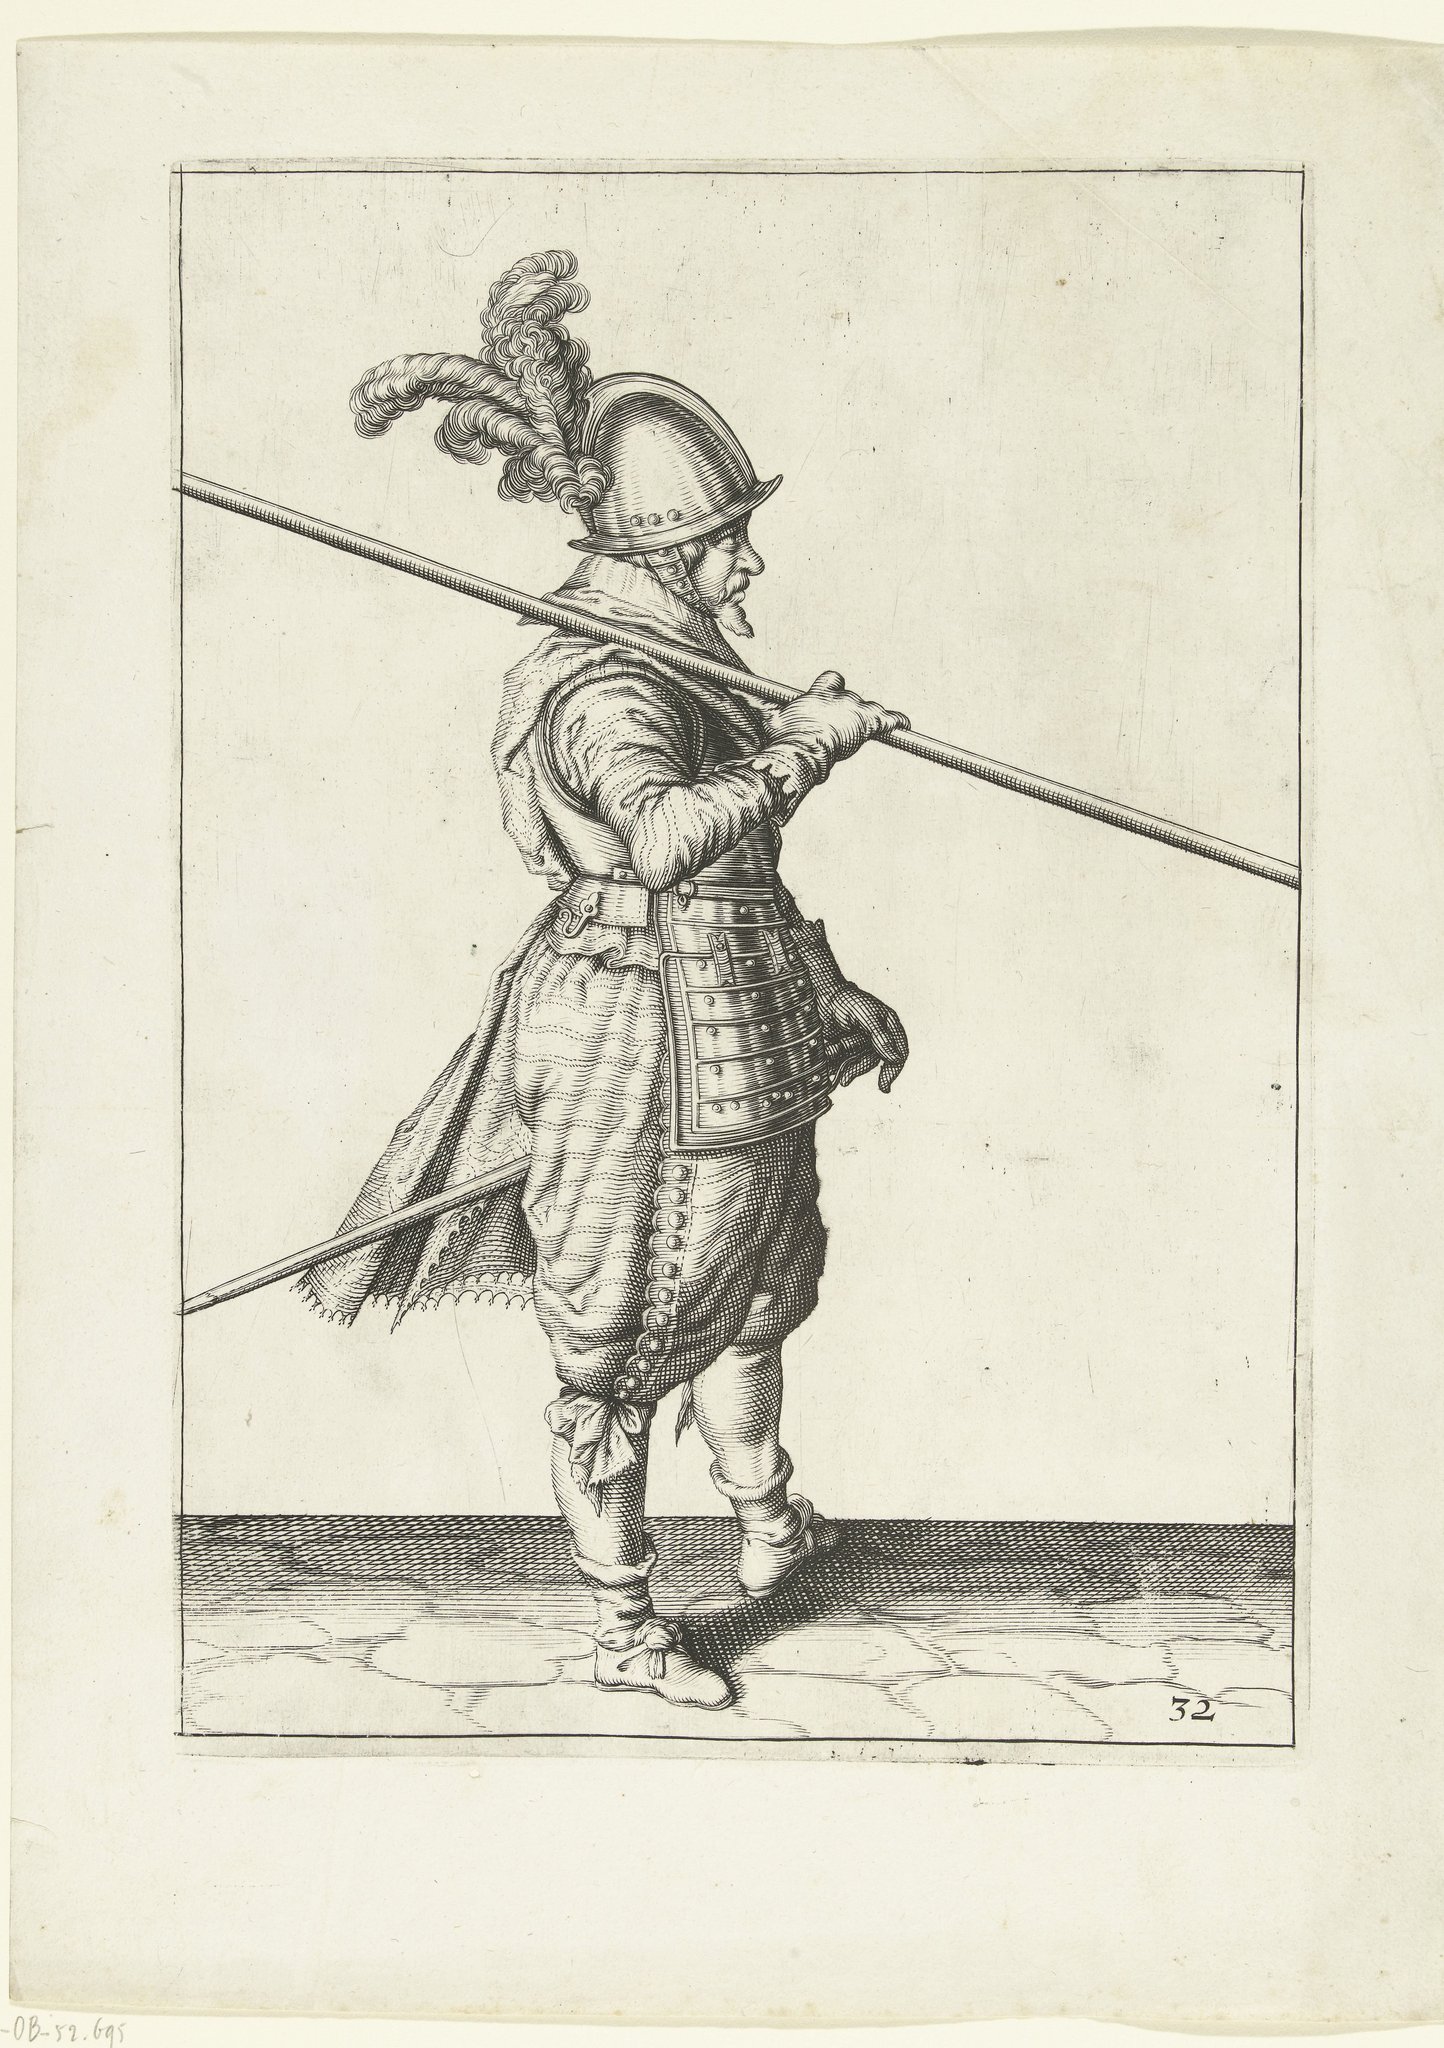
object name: print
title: Soldaat die zijn spies op zijn rechterschouder draagt, de punt schuin naar de grond gericht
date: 1597-1607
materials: paper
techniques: engraving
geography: netherlands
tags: manoeuvre ~ military training, warfare; military affairs (+ mercenary troops, e.g.: lansquenets), helved weapons, polearms (for striking, hacking, thrusting): lance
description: Een soldaat, ten voeten uit, naar rechts, die een spies (lans) op zijn rechterschouder draagt, de punt schuin naar de grond gericht. Zijn rechterhand om de spies. Deze prent is onderdeel van de reeks van 32 genummerde prenten van spiesdragers uit de Wapenhandelinghe.